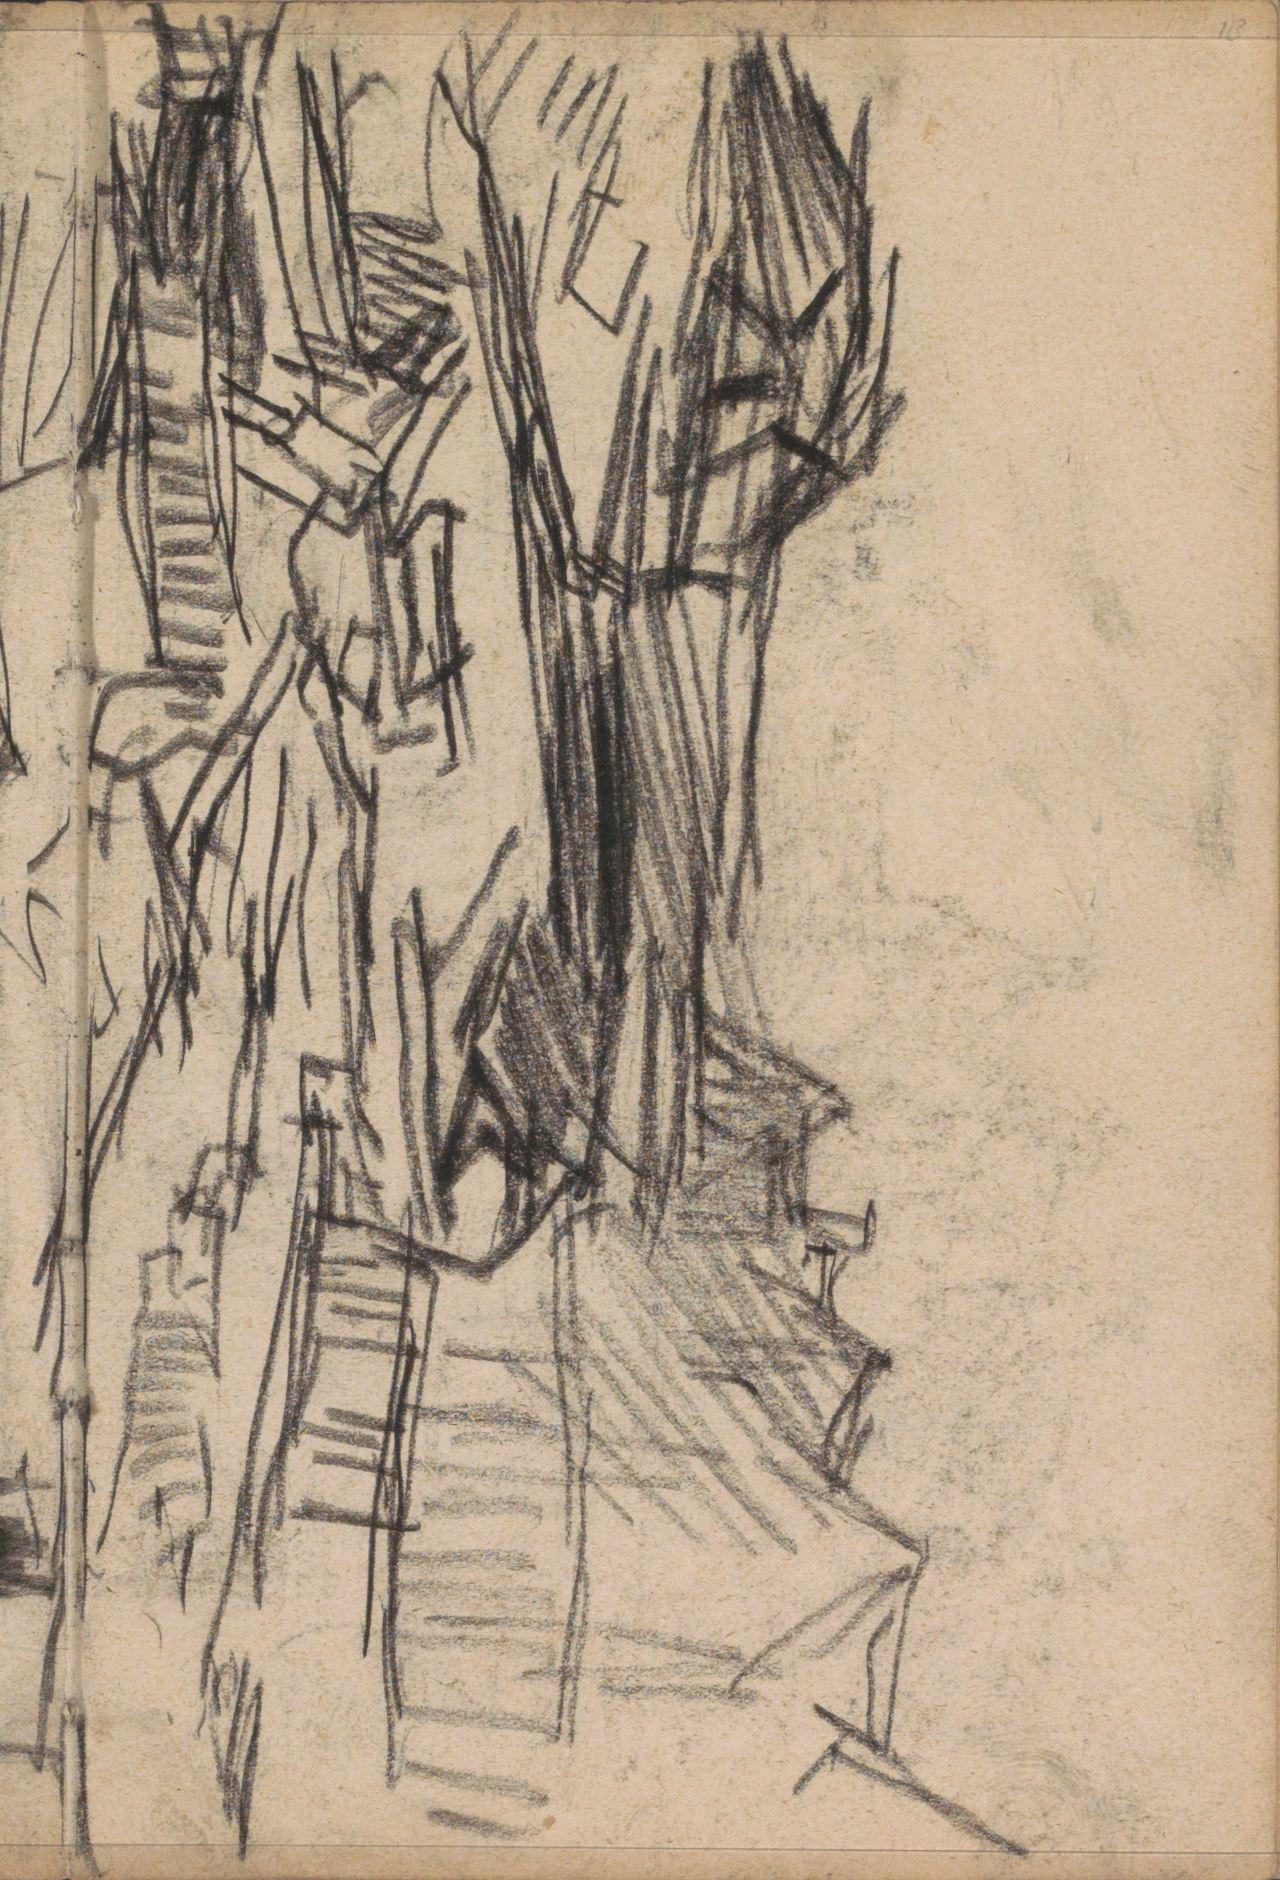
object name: sketchbook leaf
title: Gezicht te Amsterdam, mogelijk nabij Prinseneiland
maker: george hendrik breitner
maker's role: draughtsman, painter, print maker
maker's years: 1857-1923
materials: chalk, paper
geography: amsterdam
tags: building-site, civic architecture; edifices; dwellings, amsterdam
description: Pagina 18 uit een schetsboek met 46 bladen.